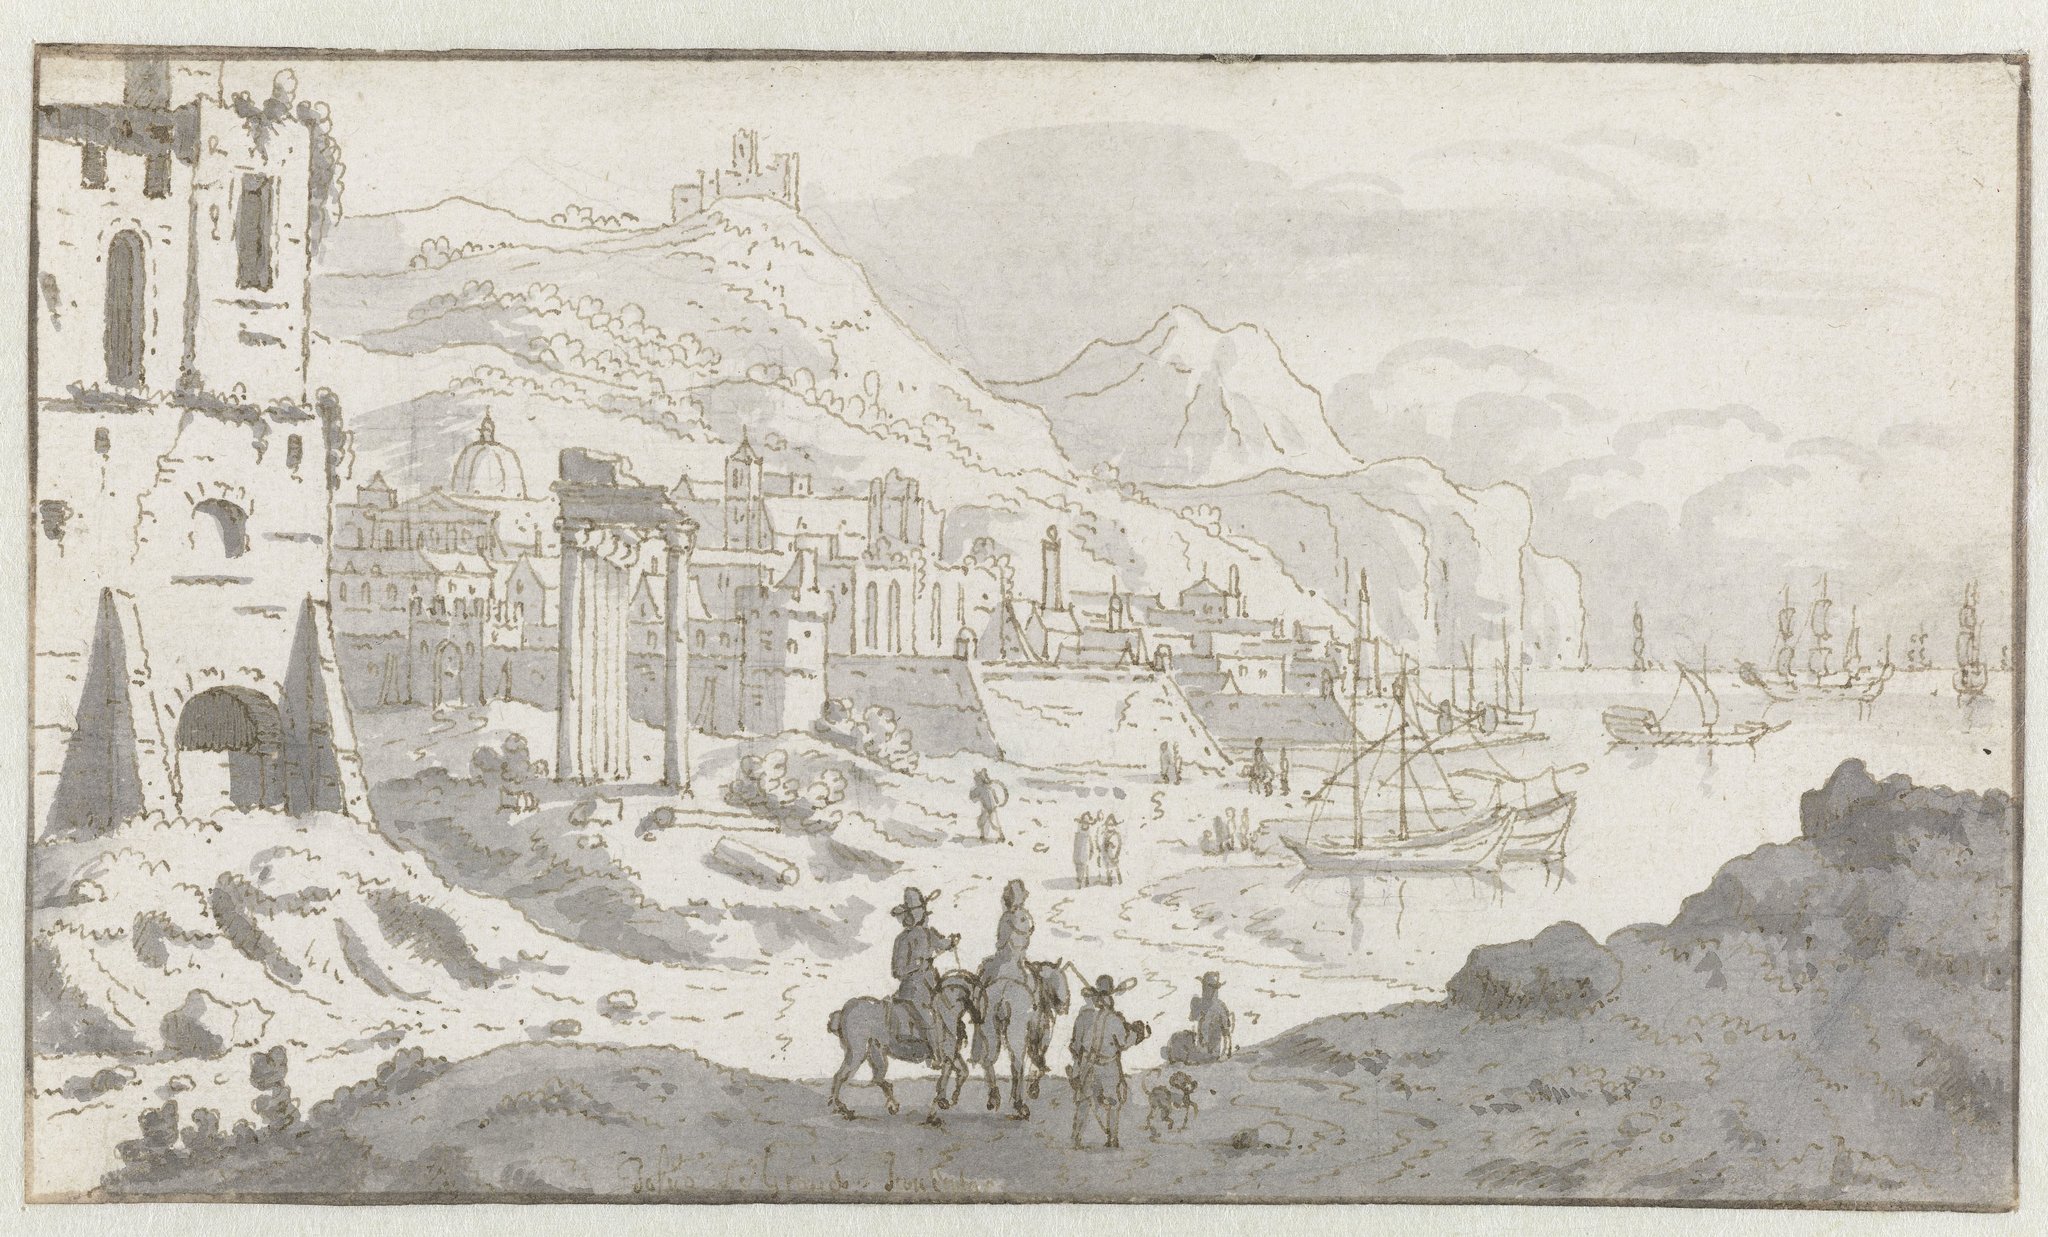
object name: drawing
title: View of an Imaginary Italianate Harbor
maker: josua de grave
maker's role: draughtsman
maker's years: 1645-1712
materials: ink, paper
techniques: brush, pen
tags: harbour, ruin of a building ~ architecture, quay